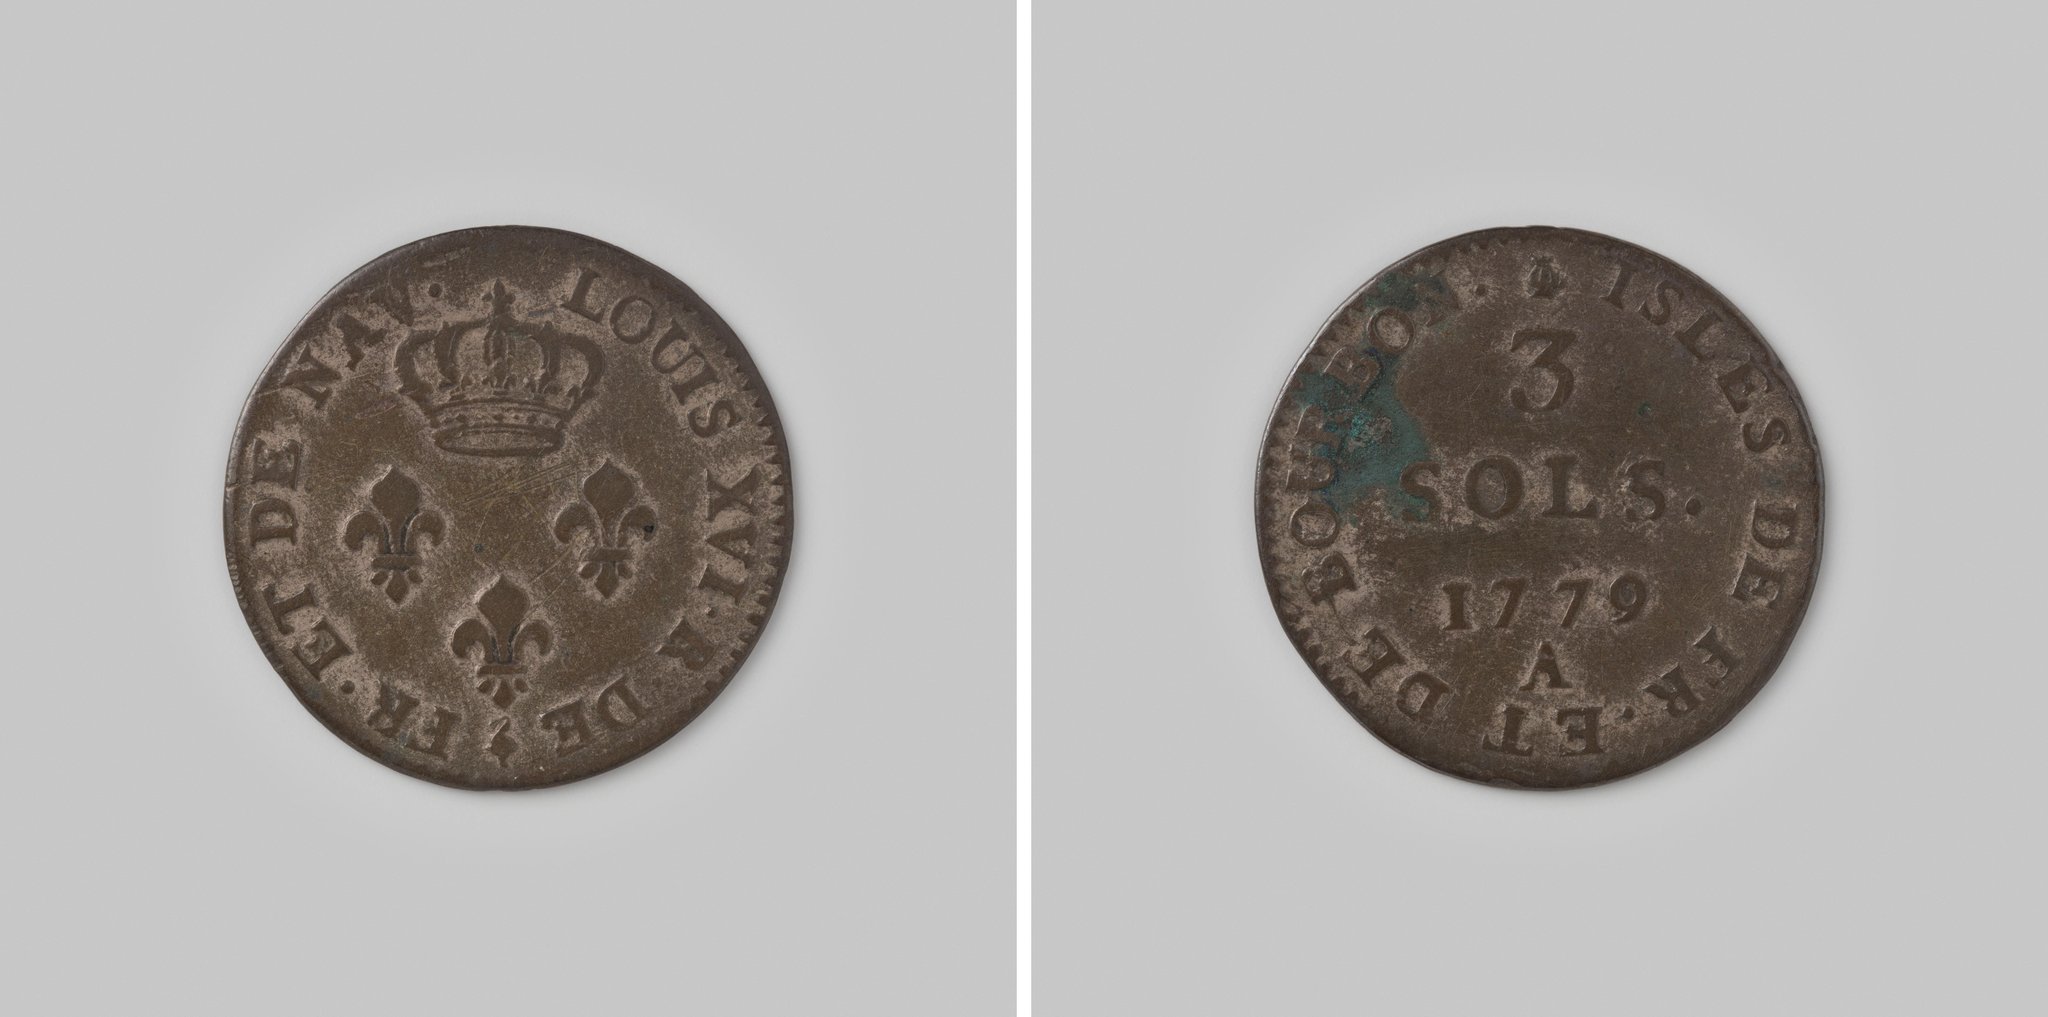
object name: coin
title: 3 sols van de Isles de France et de Bourbon tijdens Lodewijk XVI, 1779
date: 1779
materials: silver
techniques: striking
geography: paris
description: Koper-zilveren munt. Voorzijde: drie lelies van het huis Bourbon, waarboven kroon. Keerzijde: in twee regels waarde-aanduiding. Daaronder jaartal, waaronder letter A [=Parijs].